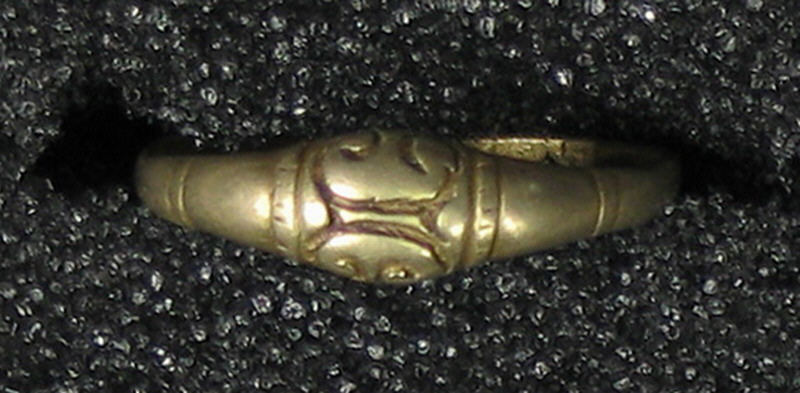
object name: ring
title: Hollow Ring, Foliate and Oval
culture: indonesian, east java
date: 1101-1400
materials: gold